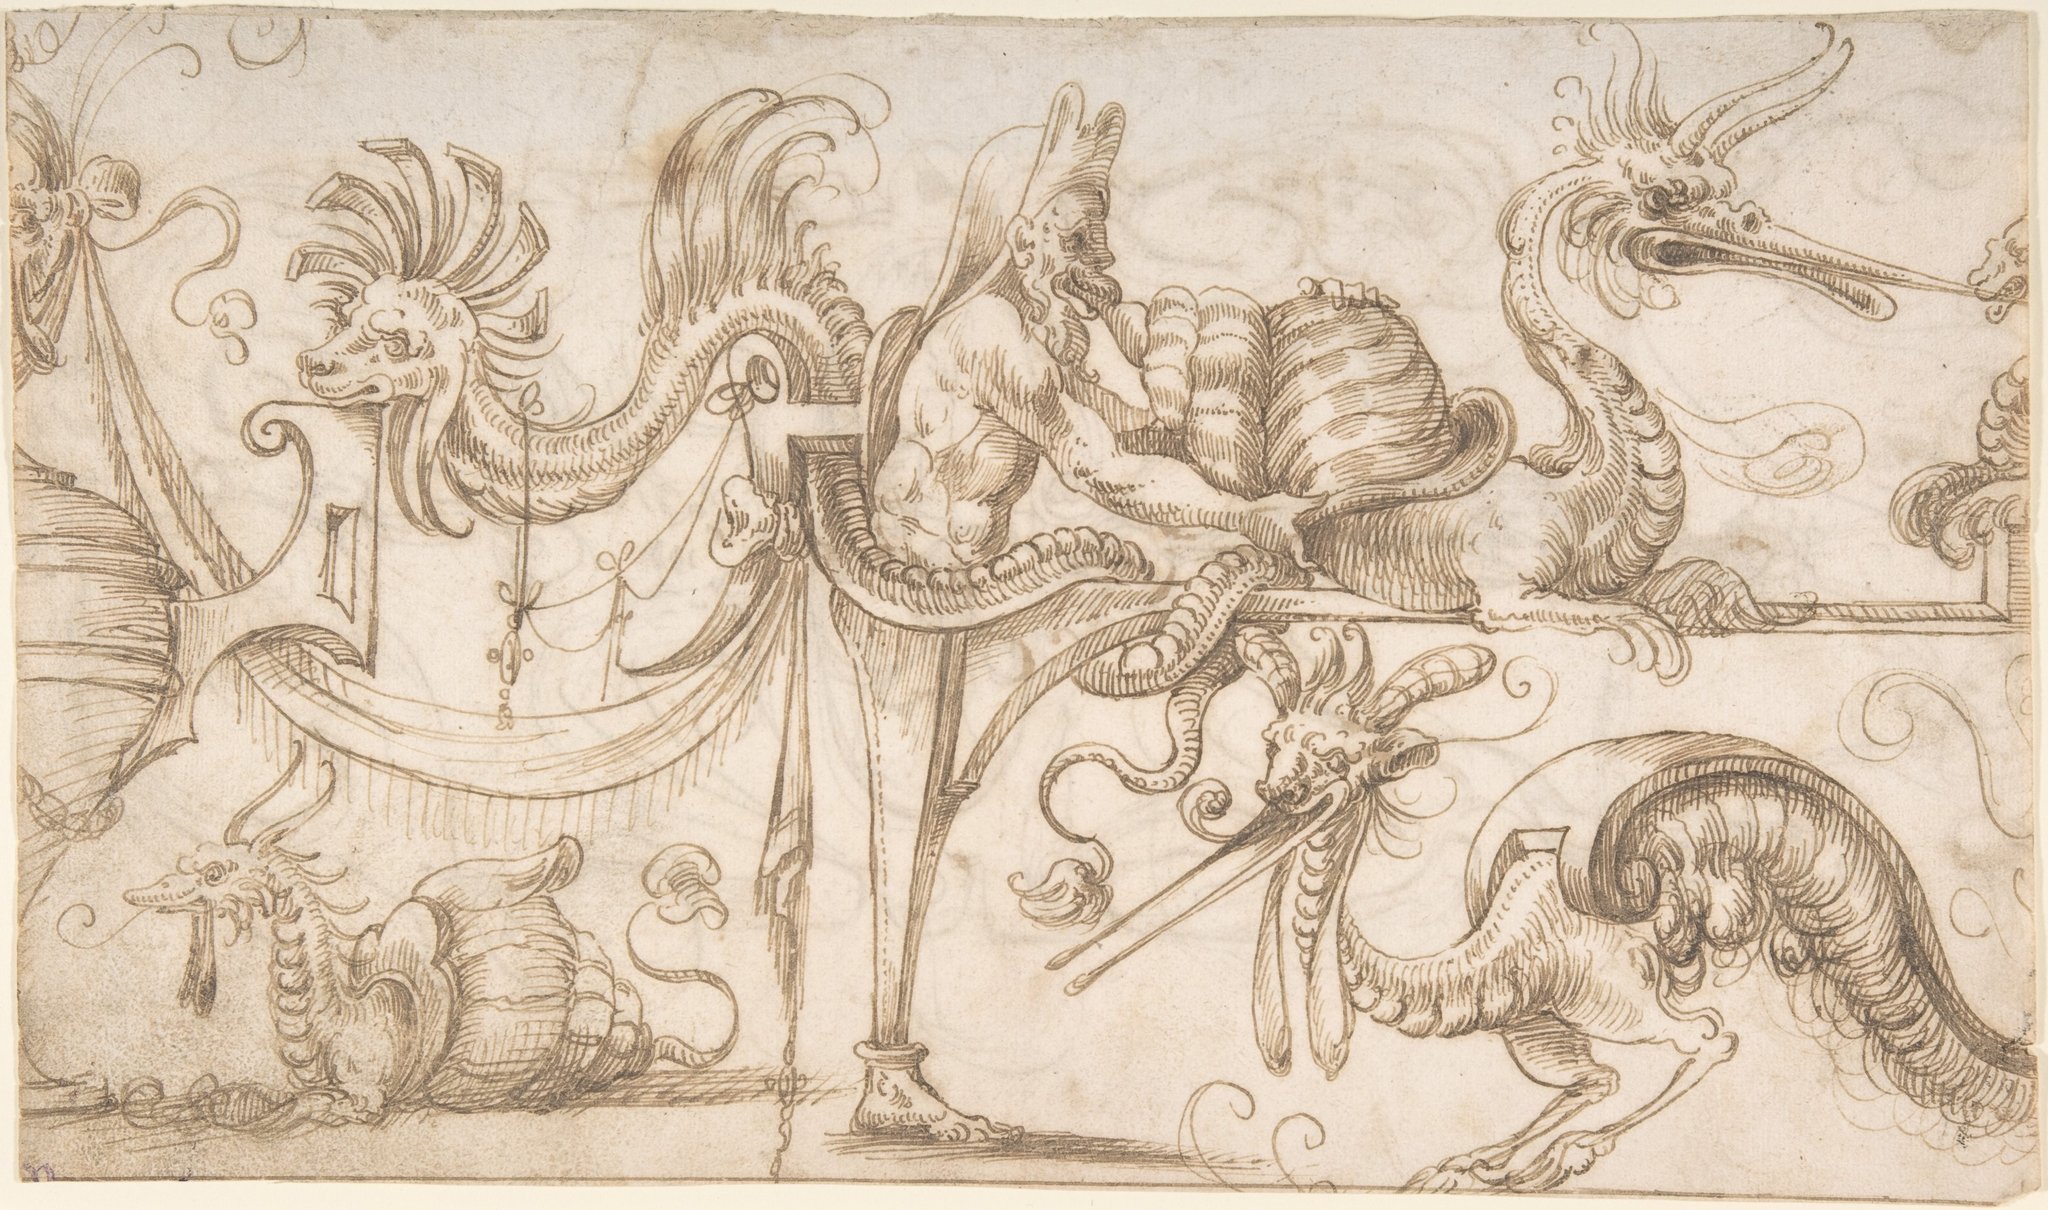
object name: drawing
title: Term with snails and strapwork (recto); Candelabra grotesque with two figures (verso)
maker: andrés de melgar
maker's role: artist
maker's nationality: spanish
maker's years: 1554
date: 1545-1560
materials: ink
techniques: pen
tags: grotesques,ornament,mythical creatures